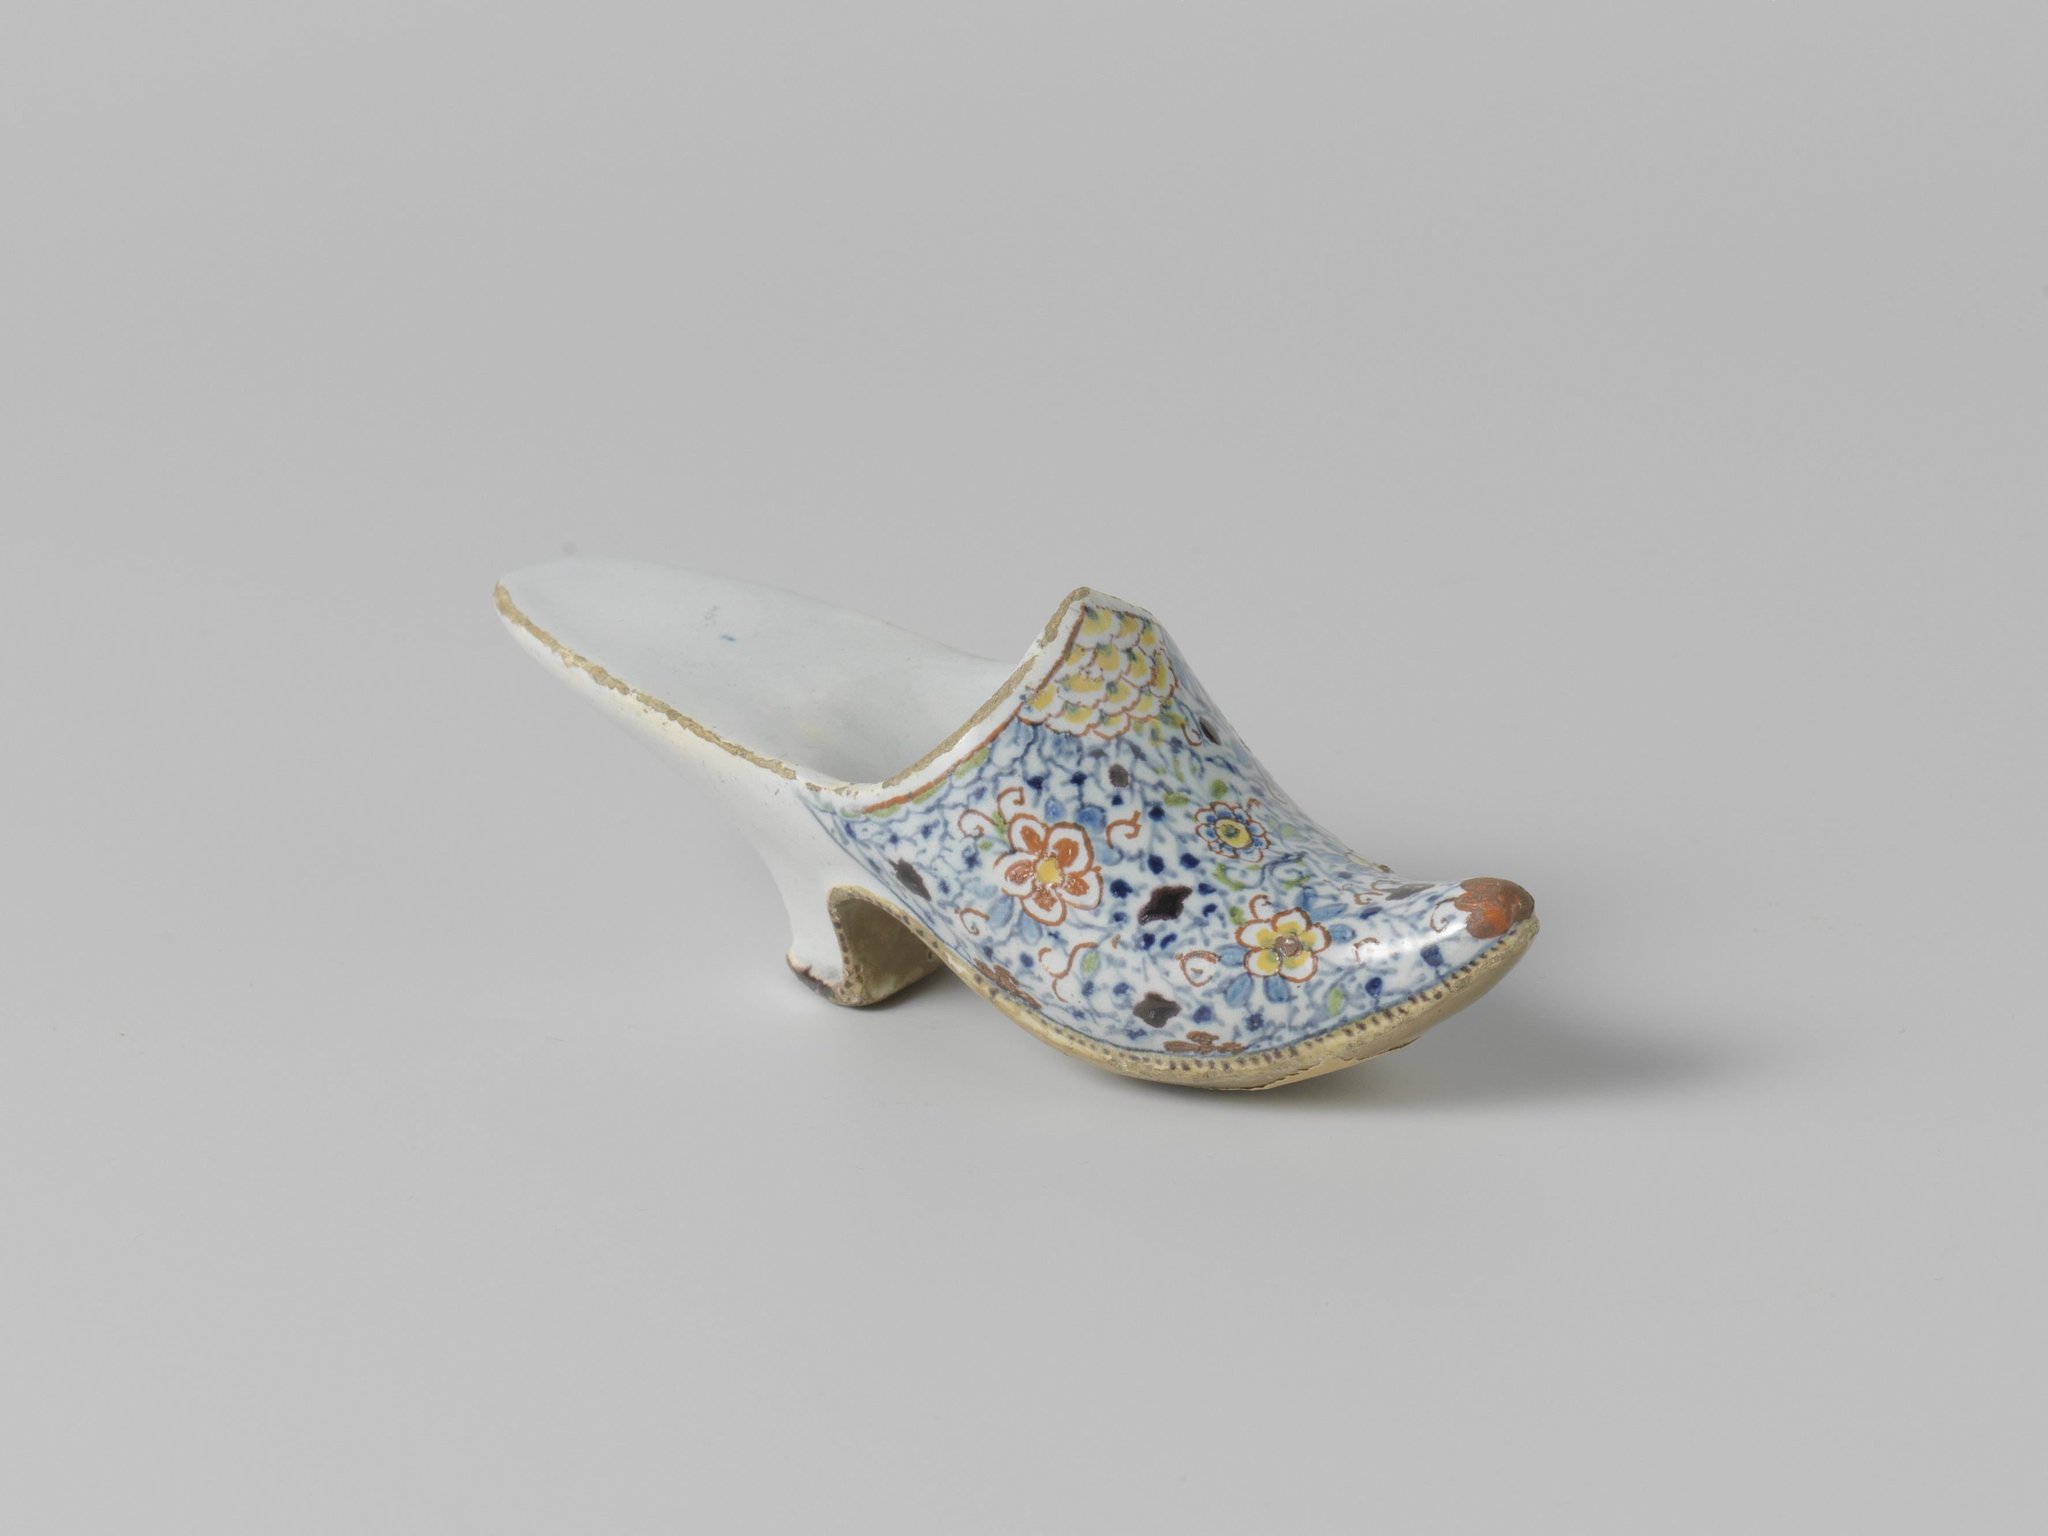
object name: decoratief object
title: Muiltje van faïence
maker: Anonymous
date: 1750-1780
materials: faience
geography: delft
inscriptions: collector's mark: ‘collection JF Loudon’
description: Muiltje van faïence. Veelkleurig beschilderd met bloemen.